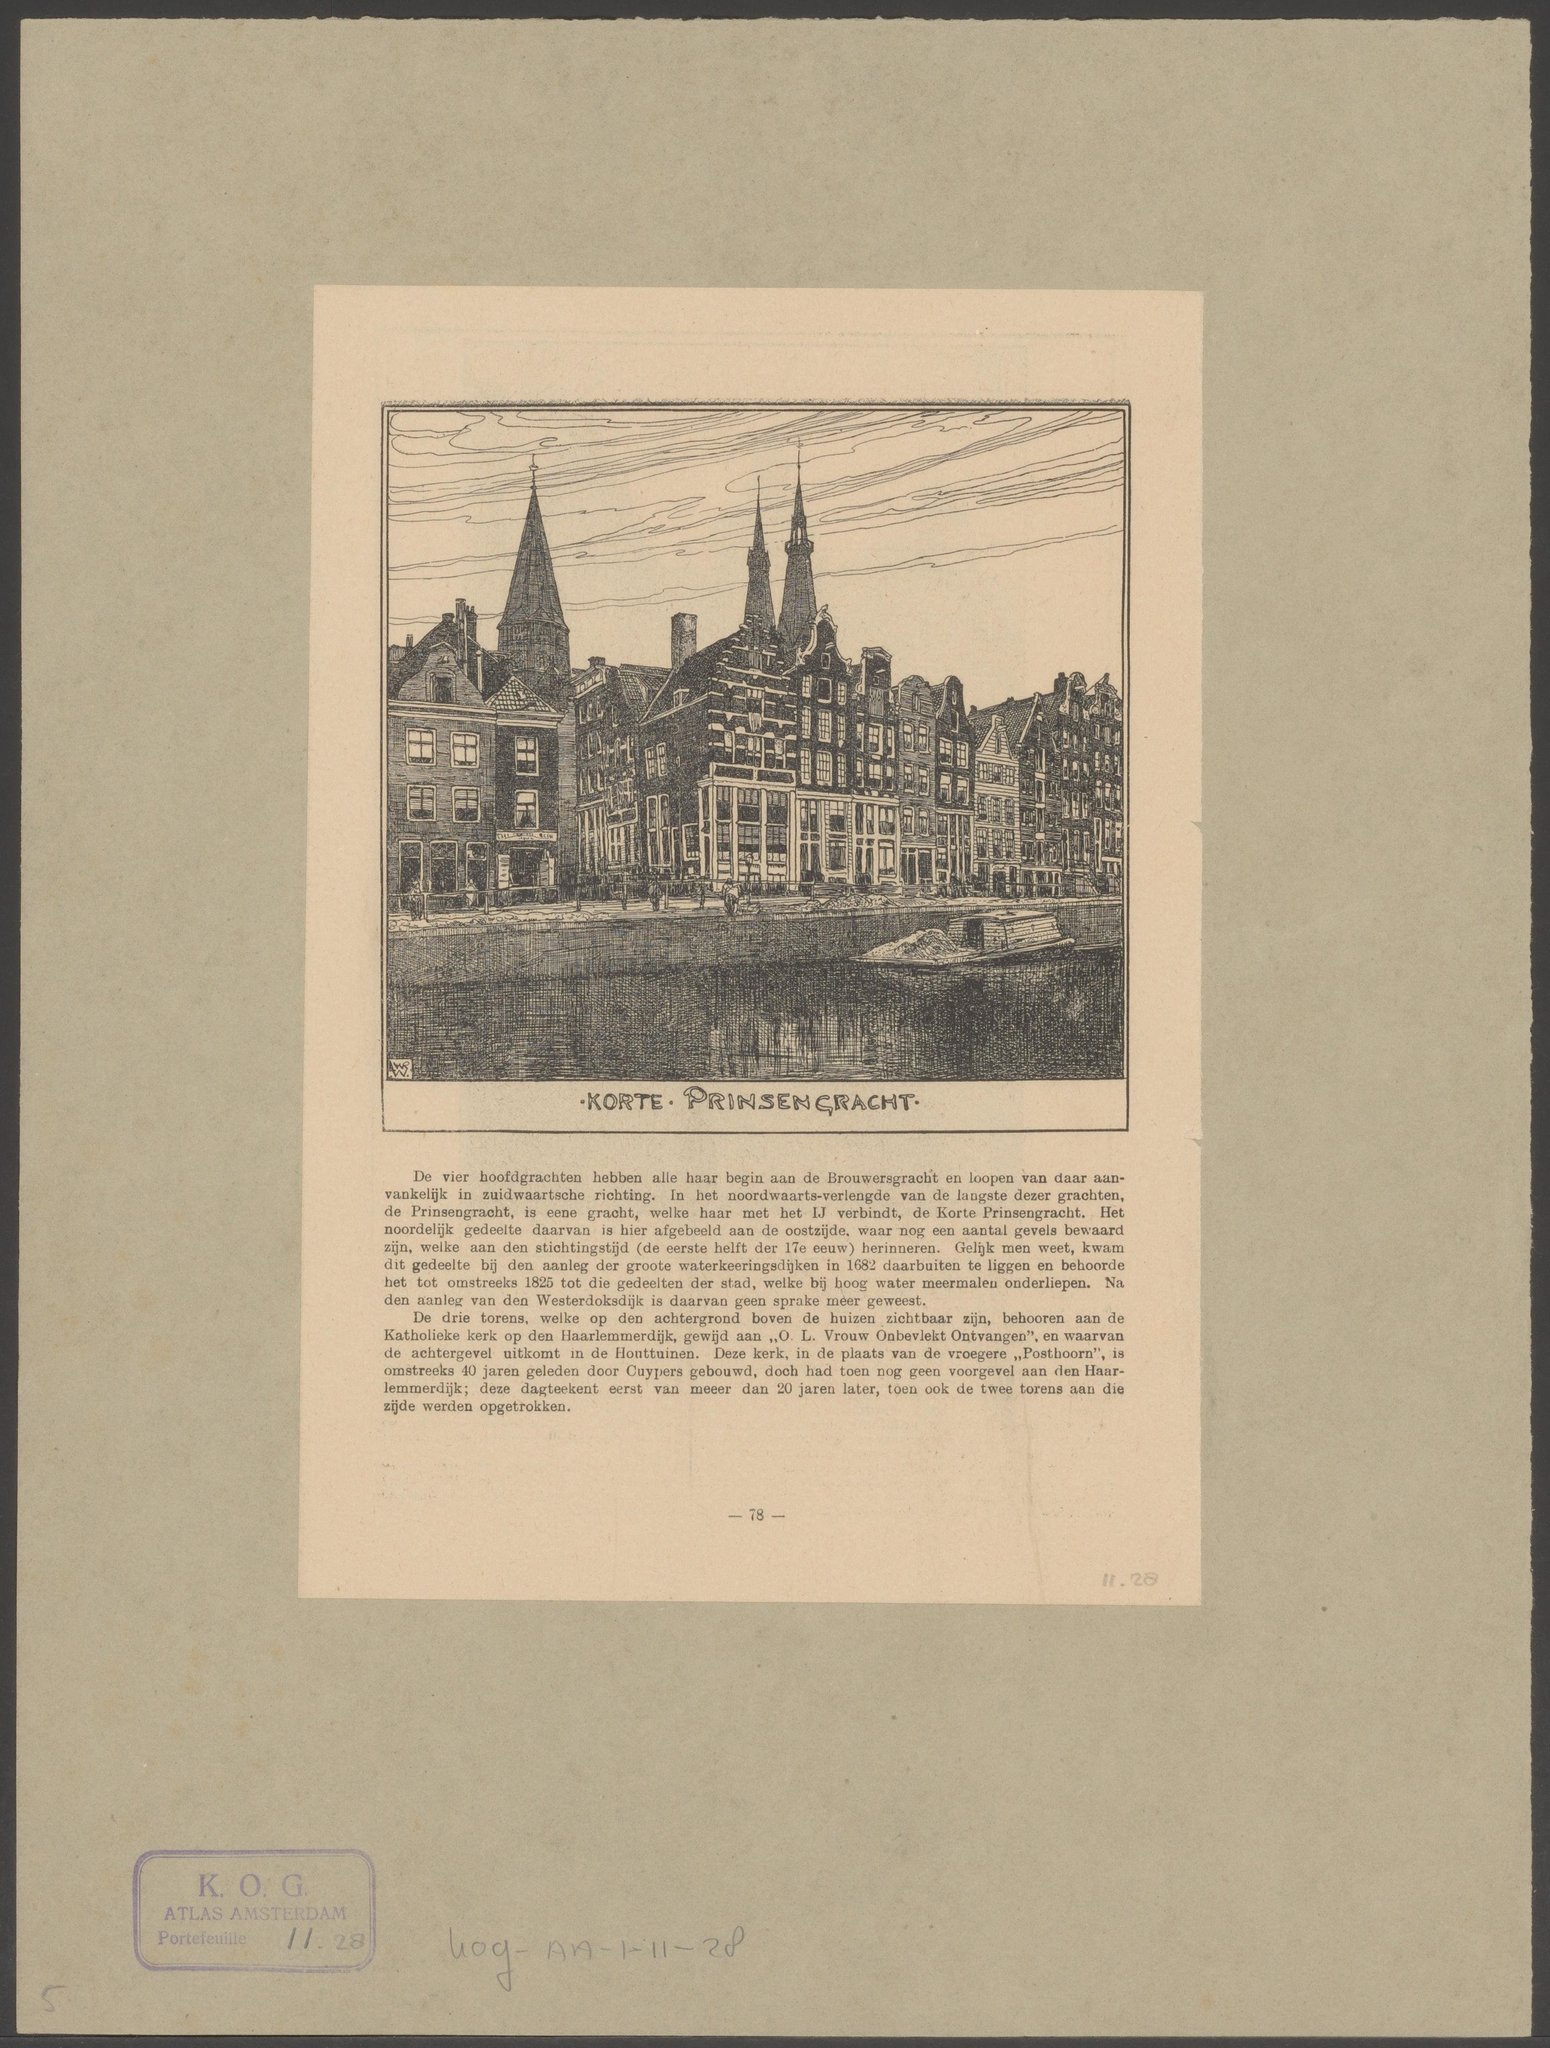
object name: page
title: Gezicht op de Korte Prinsengracht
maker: willem wenckebach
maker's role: designer, draughtsman, painter, print maker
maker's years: 1860-1937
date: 1870-1923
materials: paper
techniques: letterpress printing, line block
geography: amsterdam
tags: city-view in general; 'veduta', canal, the usual house or row of houses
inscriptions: collector's mark: ‘11.28’ Lugt 1641b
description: Onderwerpsrubriek binnen de Atlas Amsterdam: Prinsengracht, Korte Prinsengracht, Prins Hendrikkade. Zie ook Portefeuille 1: gezichten van het IJ op de stad.